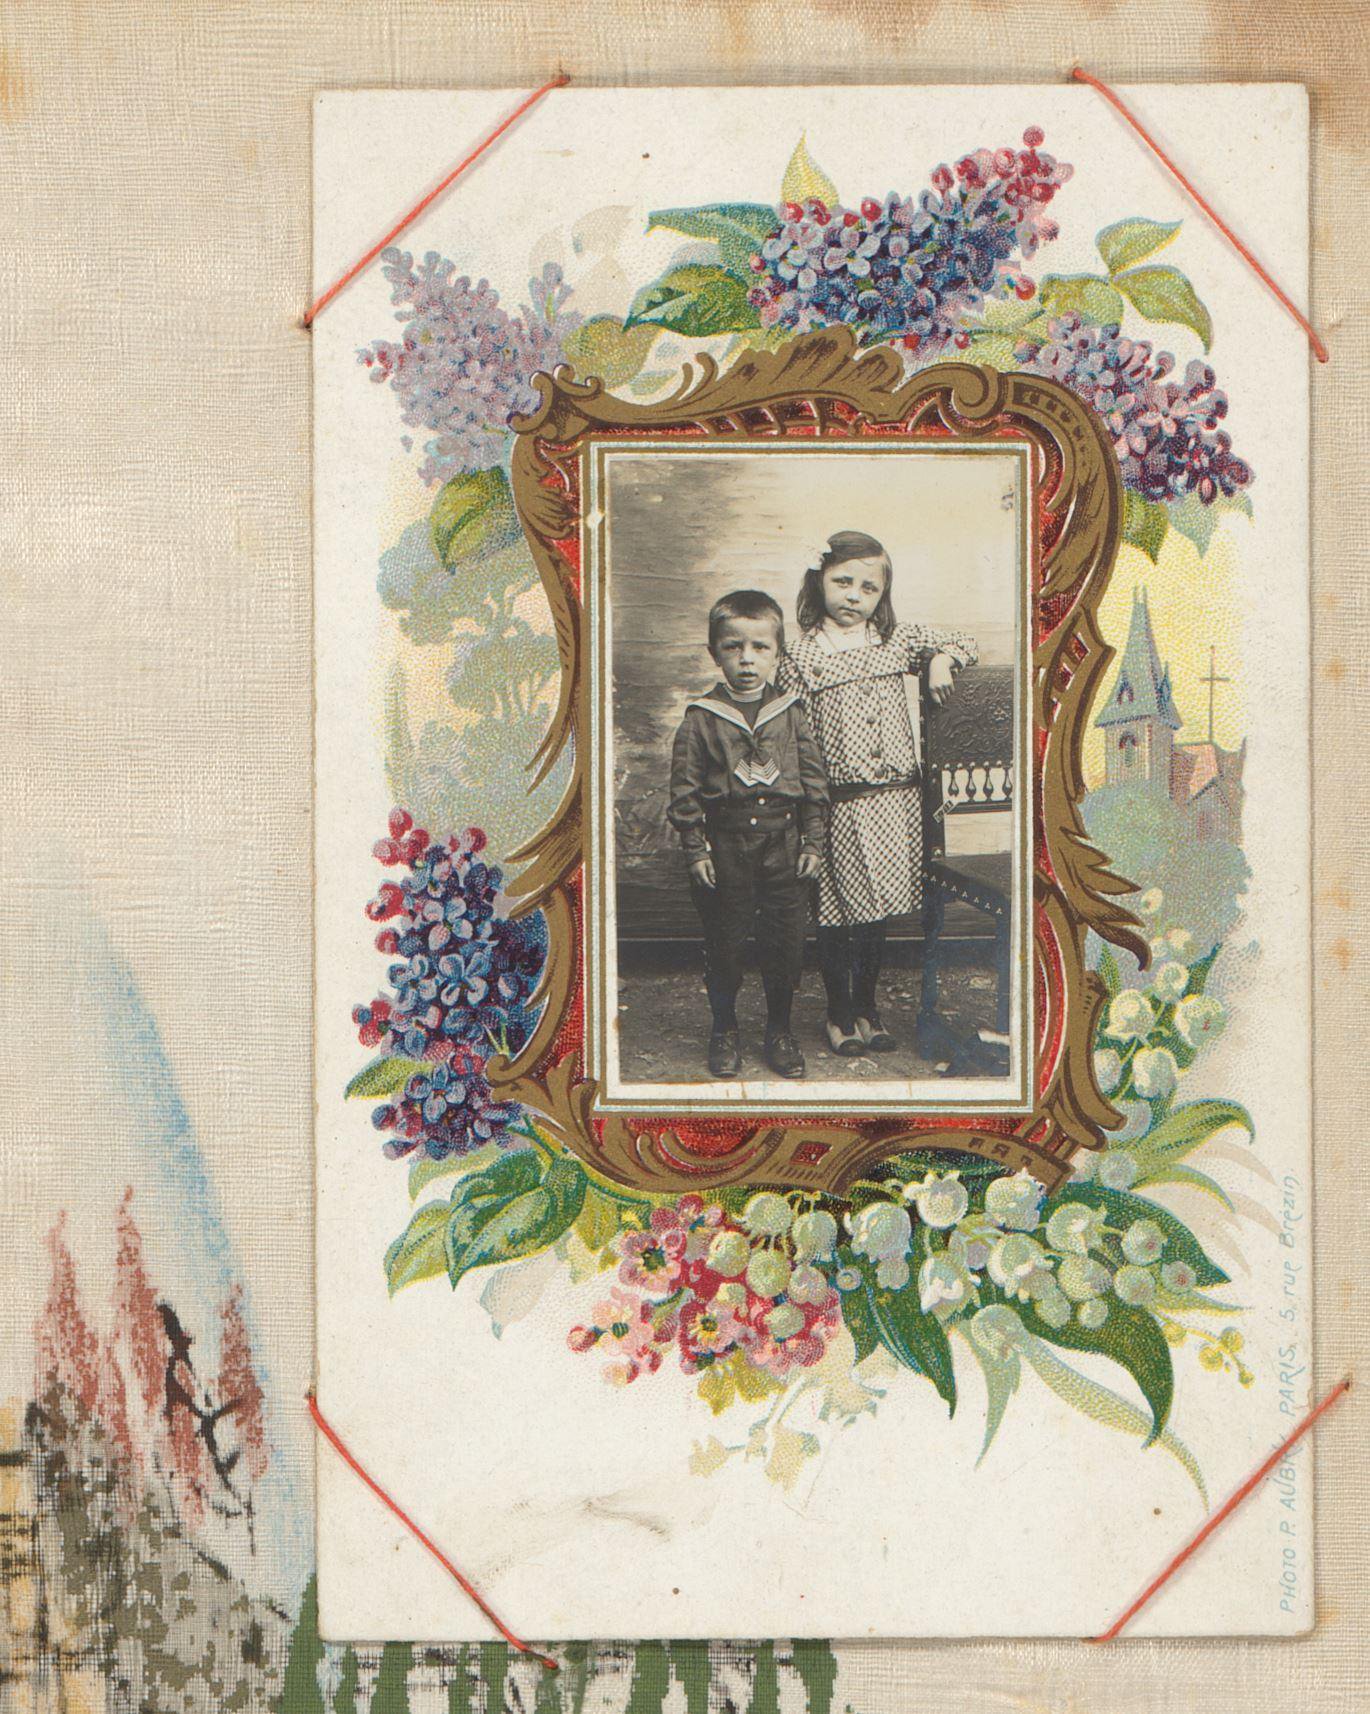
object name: photograph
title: Portret van een meisje en jongen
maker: Anonymous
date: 1880-1910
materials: cardboard, paint, photographic support, silk, textile, watercolor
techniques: brush, gelatin silver print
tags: flowers, boy (child between toddler and youth), historical persons, girl (child between toddler and youth)